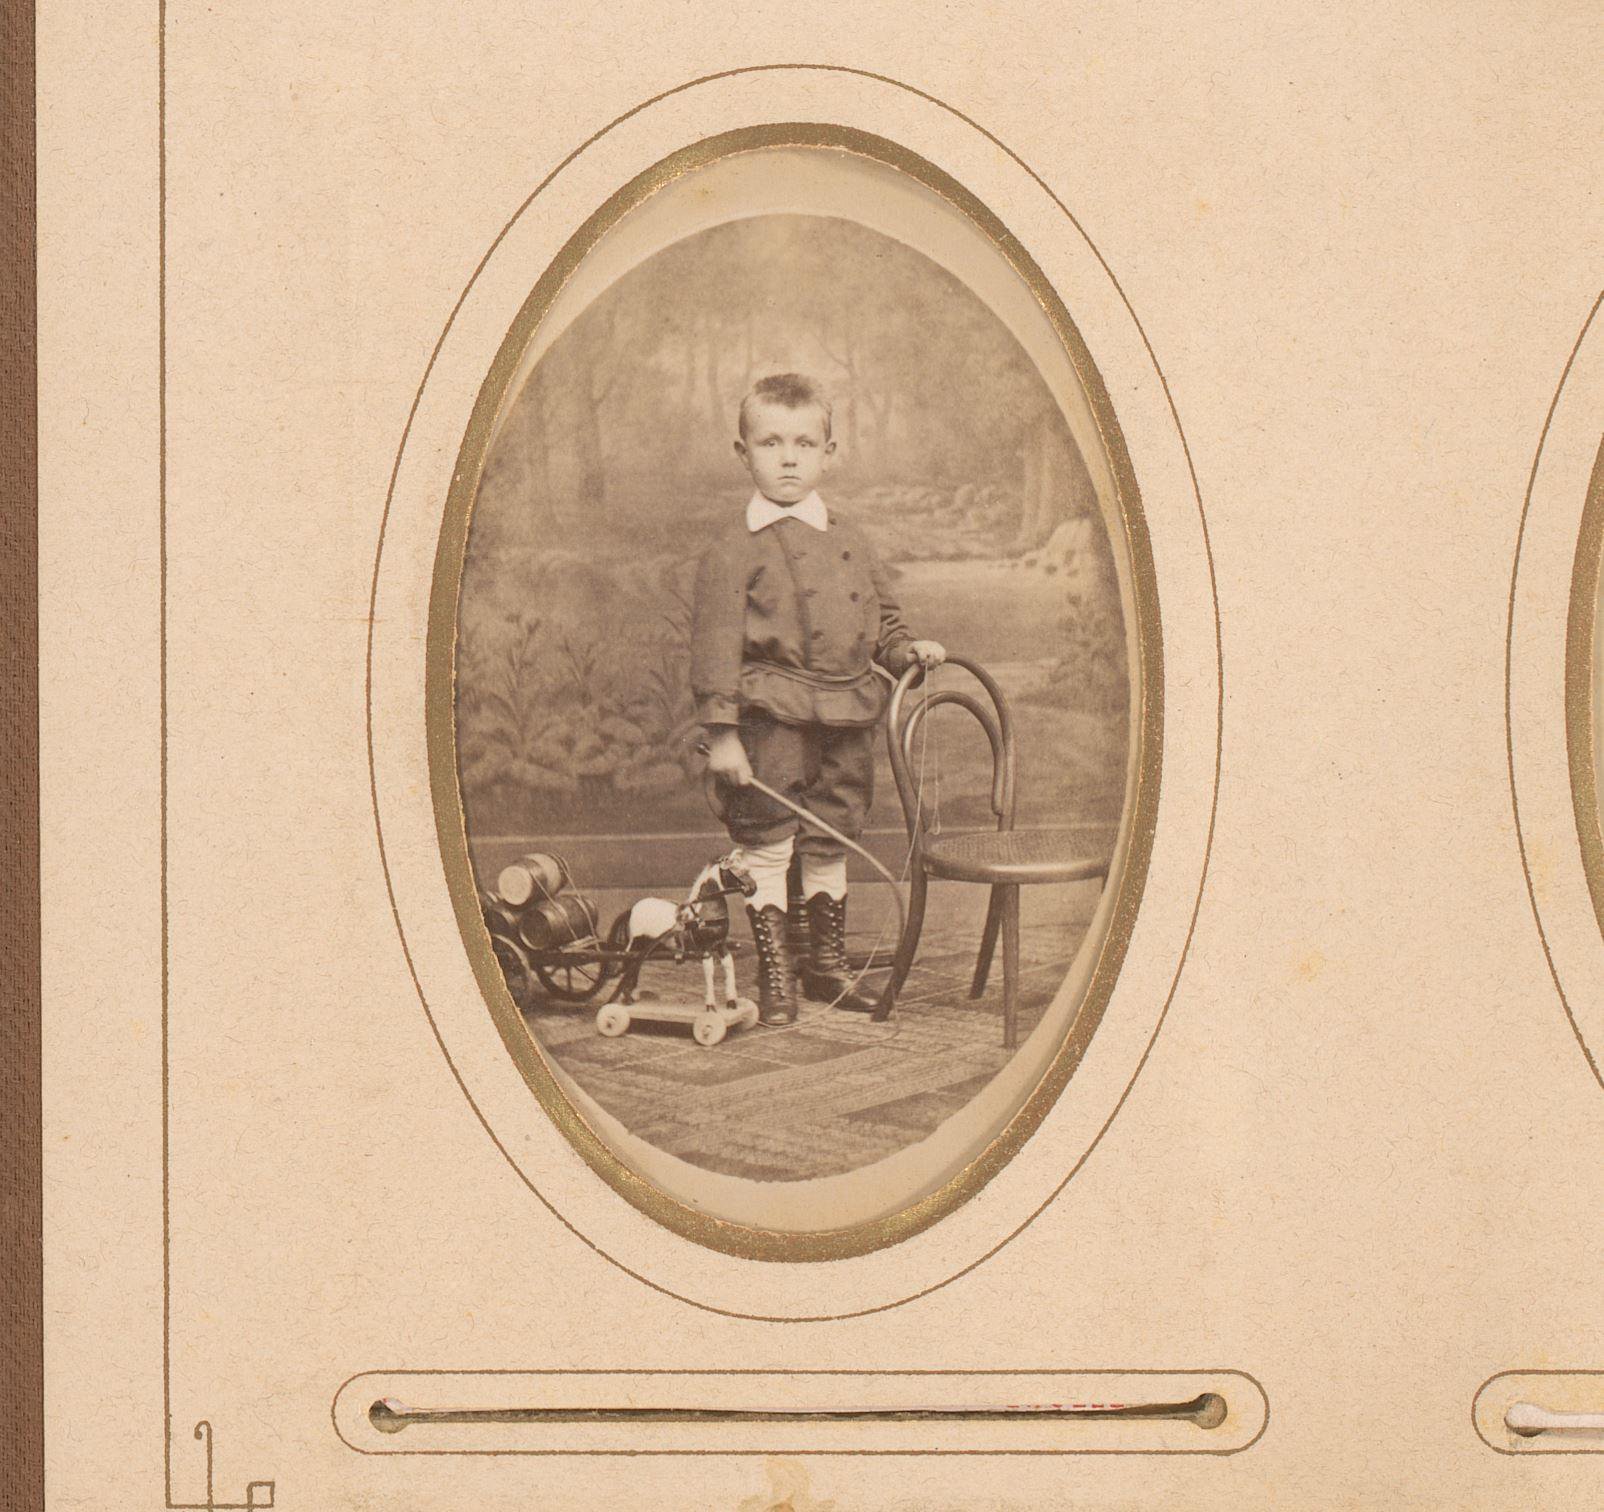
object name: photograph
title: Portret van een jongen met hobbypaard, staand bij een stoel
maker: Anonymous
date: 1880-1900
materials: cardboard, photographic support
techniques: albumen print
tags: boy (child between toddler and youth), hobby-horse, historical persons